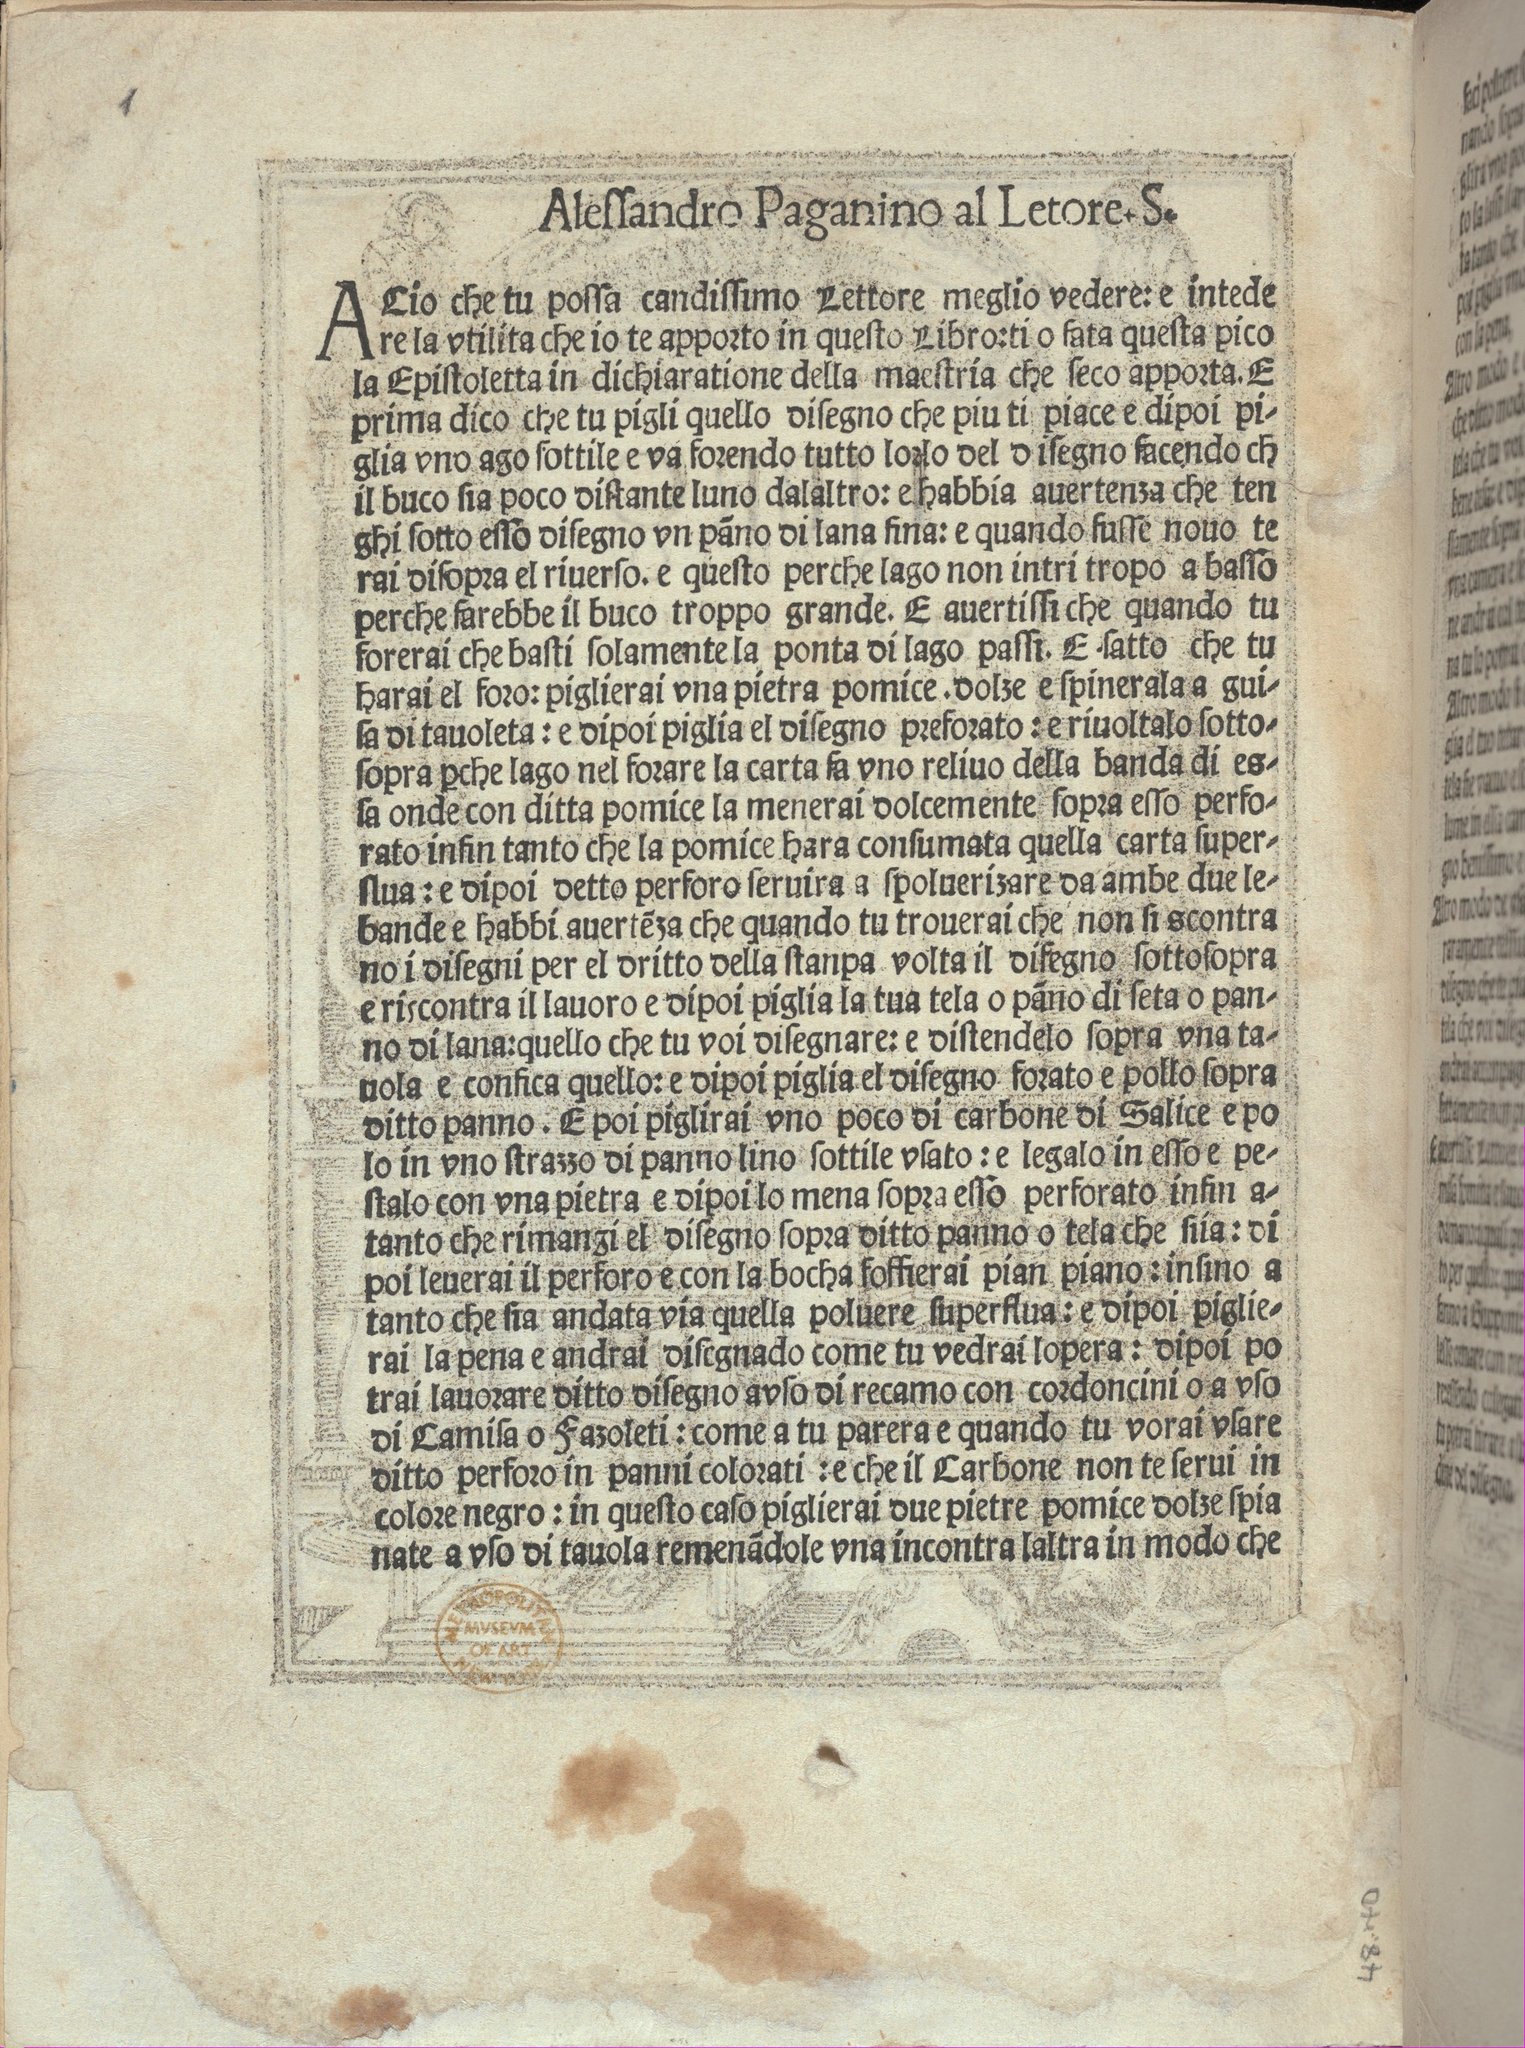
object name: book print ornament architecture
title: Libro quarto. De rechami per elquale se impara in diuersi modi lordine e il modo de recamare...Opera noua, title page (verso)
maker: alessandro paganino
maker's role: publisher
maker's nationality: italian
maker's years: 1500-1550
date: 1532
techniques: woodcut